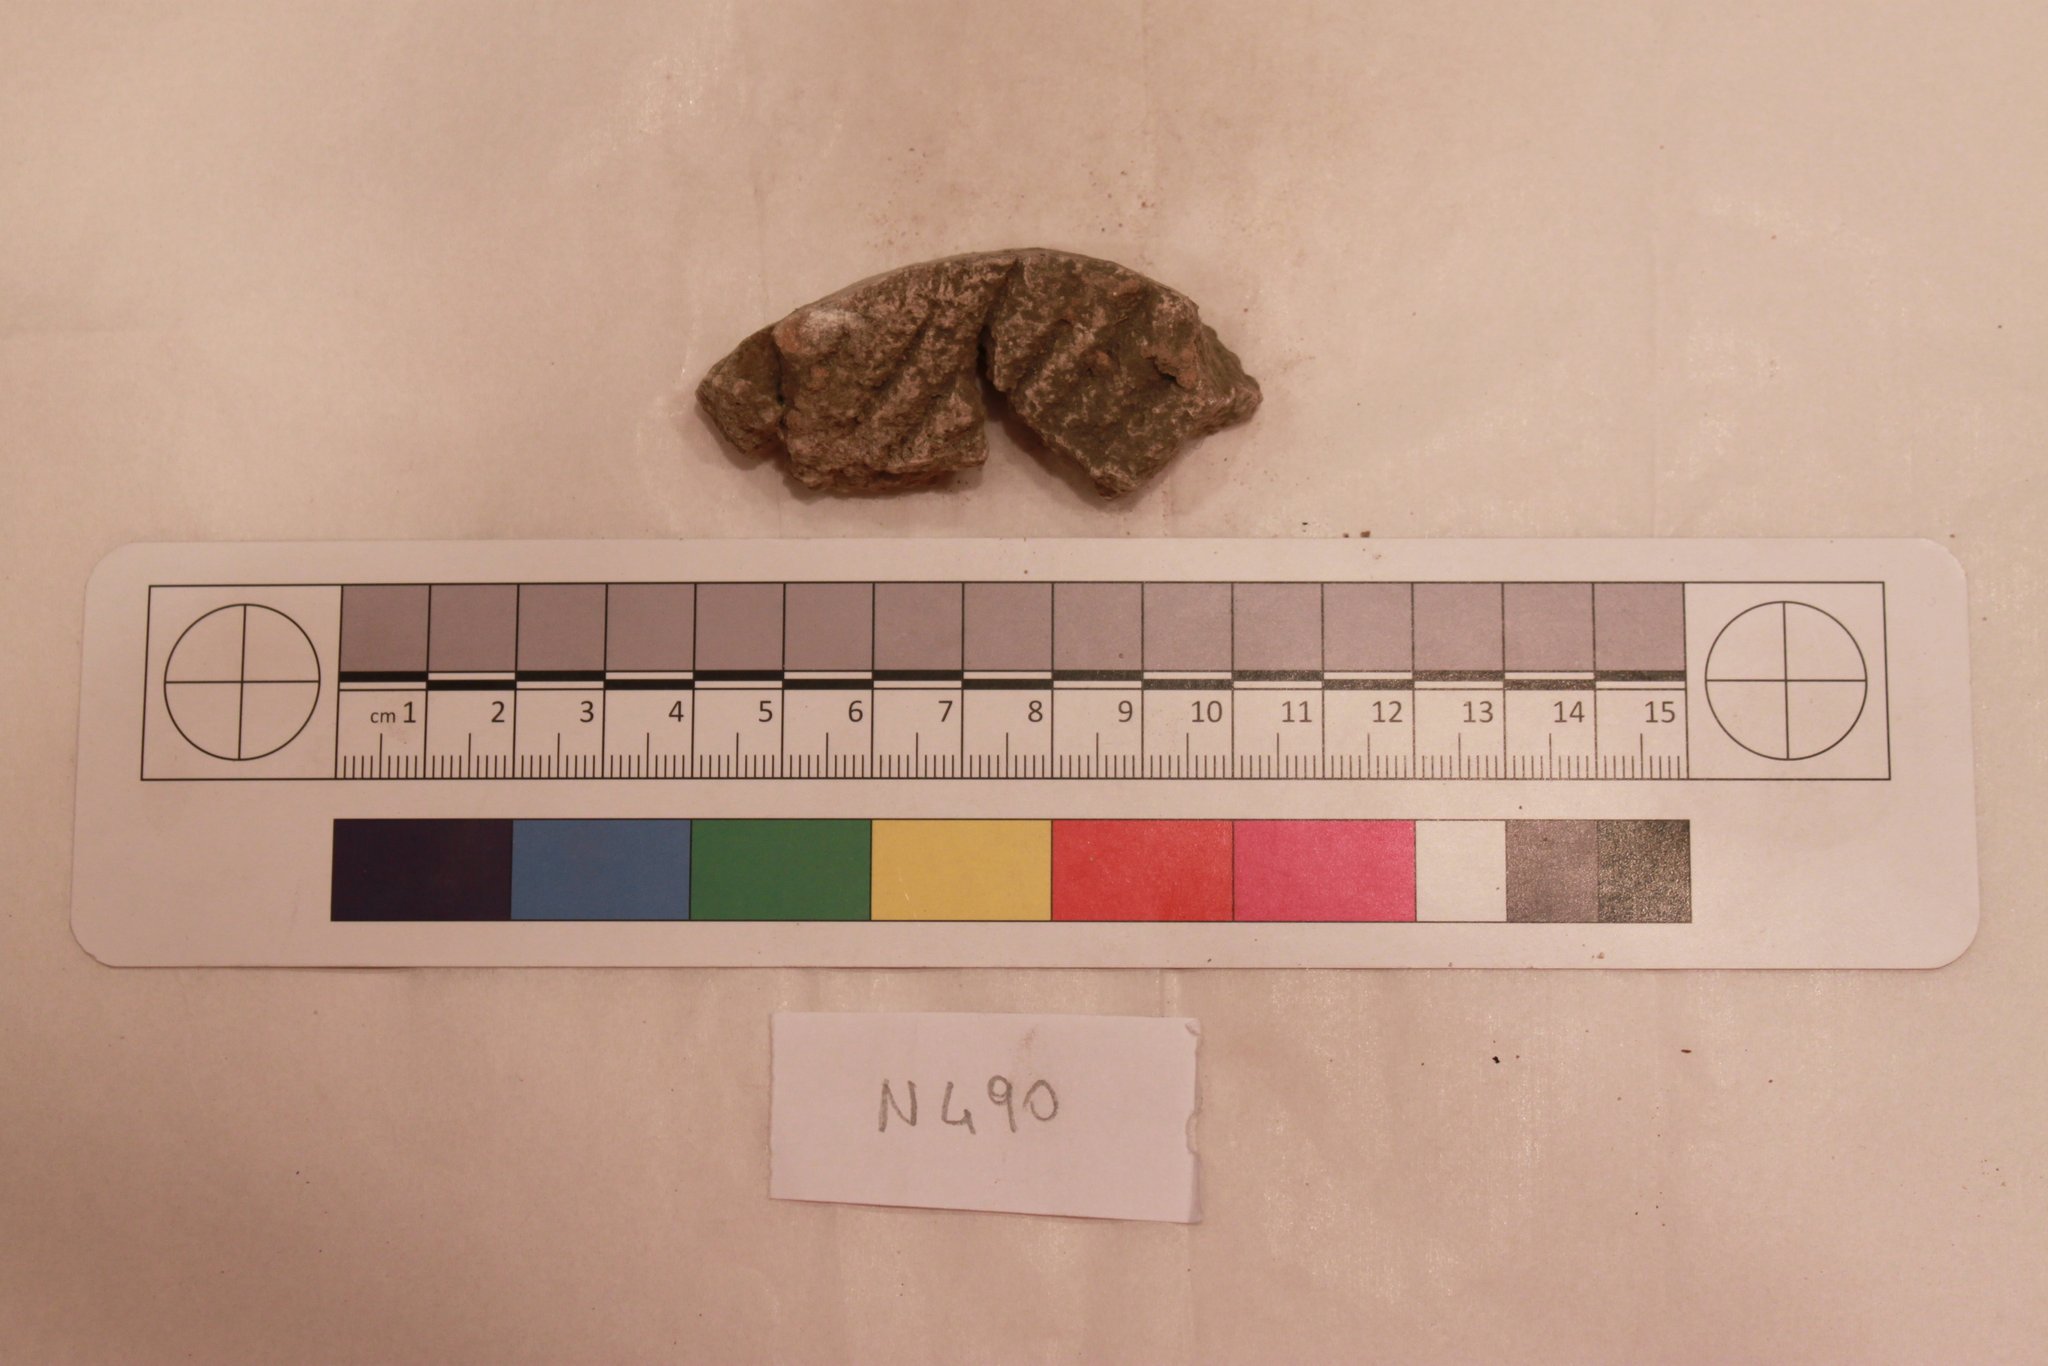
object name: fragment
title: Stucco Fragment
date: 701-1200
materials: plaster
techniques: carving, painting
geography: iran